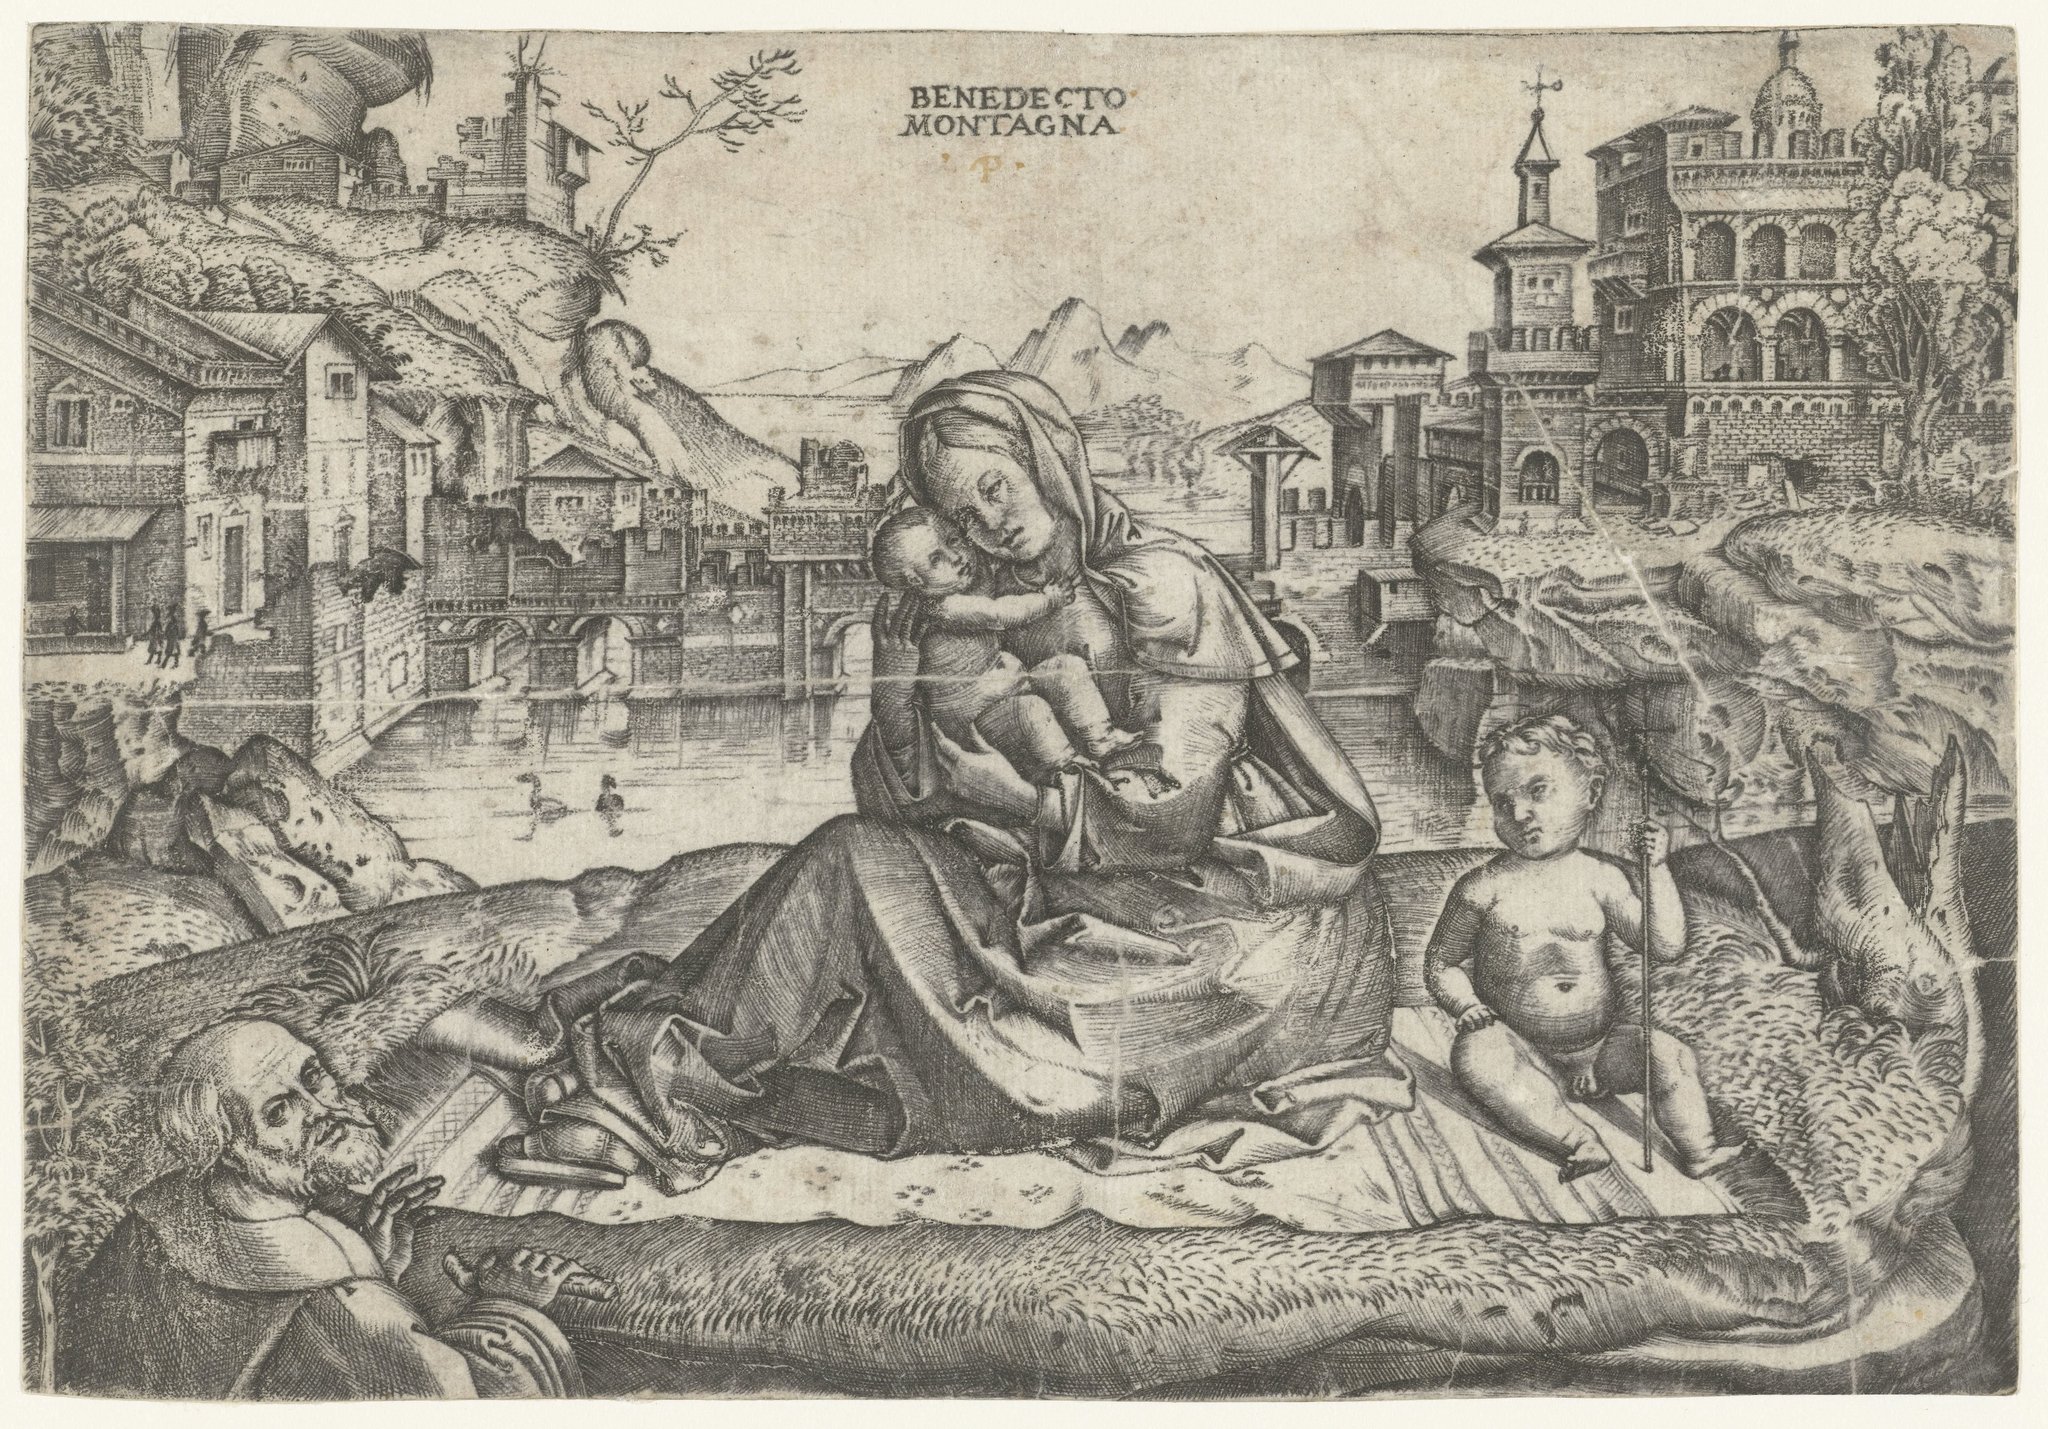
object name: print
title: De Heilige Familie met Johannes de Doper in landschap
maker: benedetto montagna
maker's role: print maker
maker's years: 1481-1558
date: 1507-1515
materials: paper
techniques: engraving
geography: italy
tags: holy family with john the baptist (as child)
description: Voor het werk van Benedetto Montagna in deze periode (1507-1515) geldt als algemene inspiratiebron Albrecht Dürer. Daarnaast worden ook werken van Andrea Mantegna en Bartolomeo Benedetto genoemd als bron voor dit werk (zie documentatie).